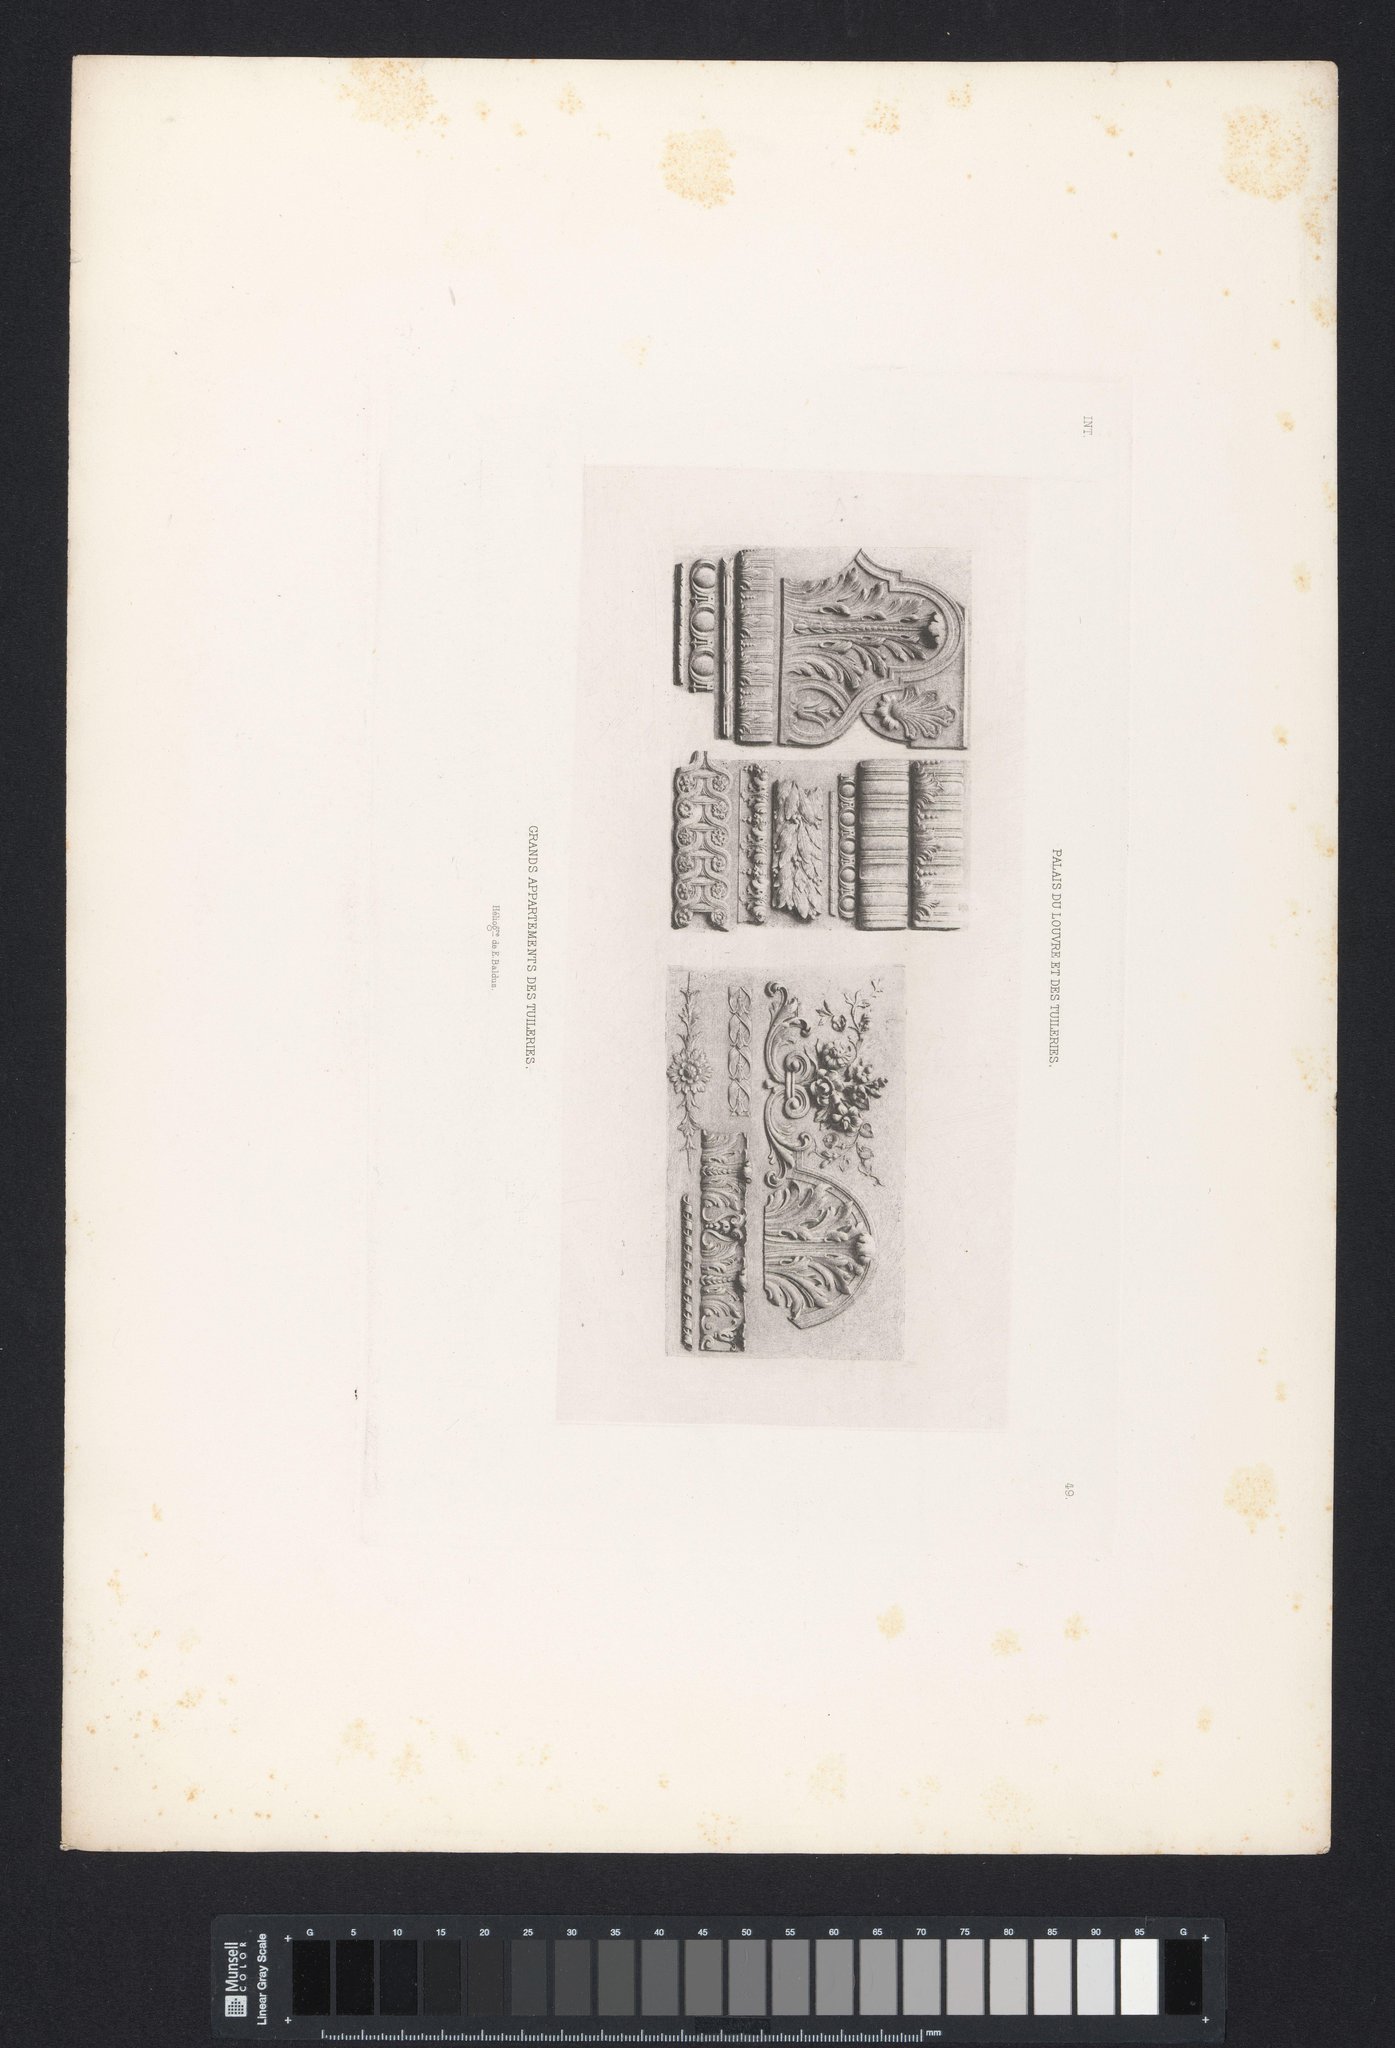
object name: photomechanical print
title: Reliëfs uit het Palais des Tuileries te Parijs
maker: édouard denis baldus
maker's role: fotograaf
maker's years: 1813-1889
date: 1865-1870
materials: paper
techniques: photoaquatint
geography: france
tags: ornaments ~ art, sculpture (+ relief ~ sculpture)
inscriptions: number: ‘Int. 49.’